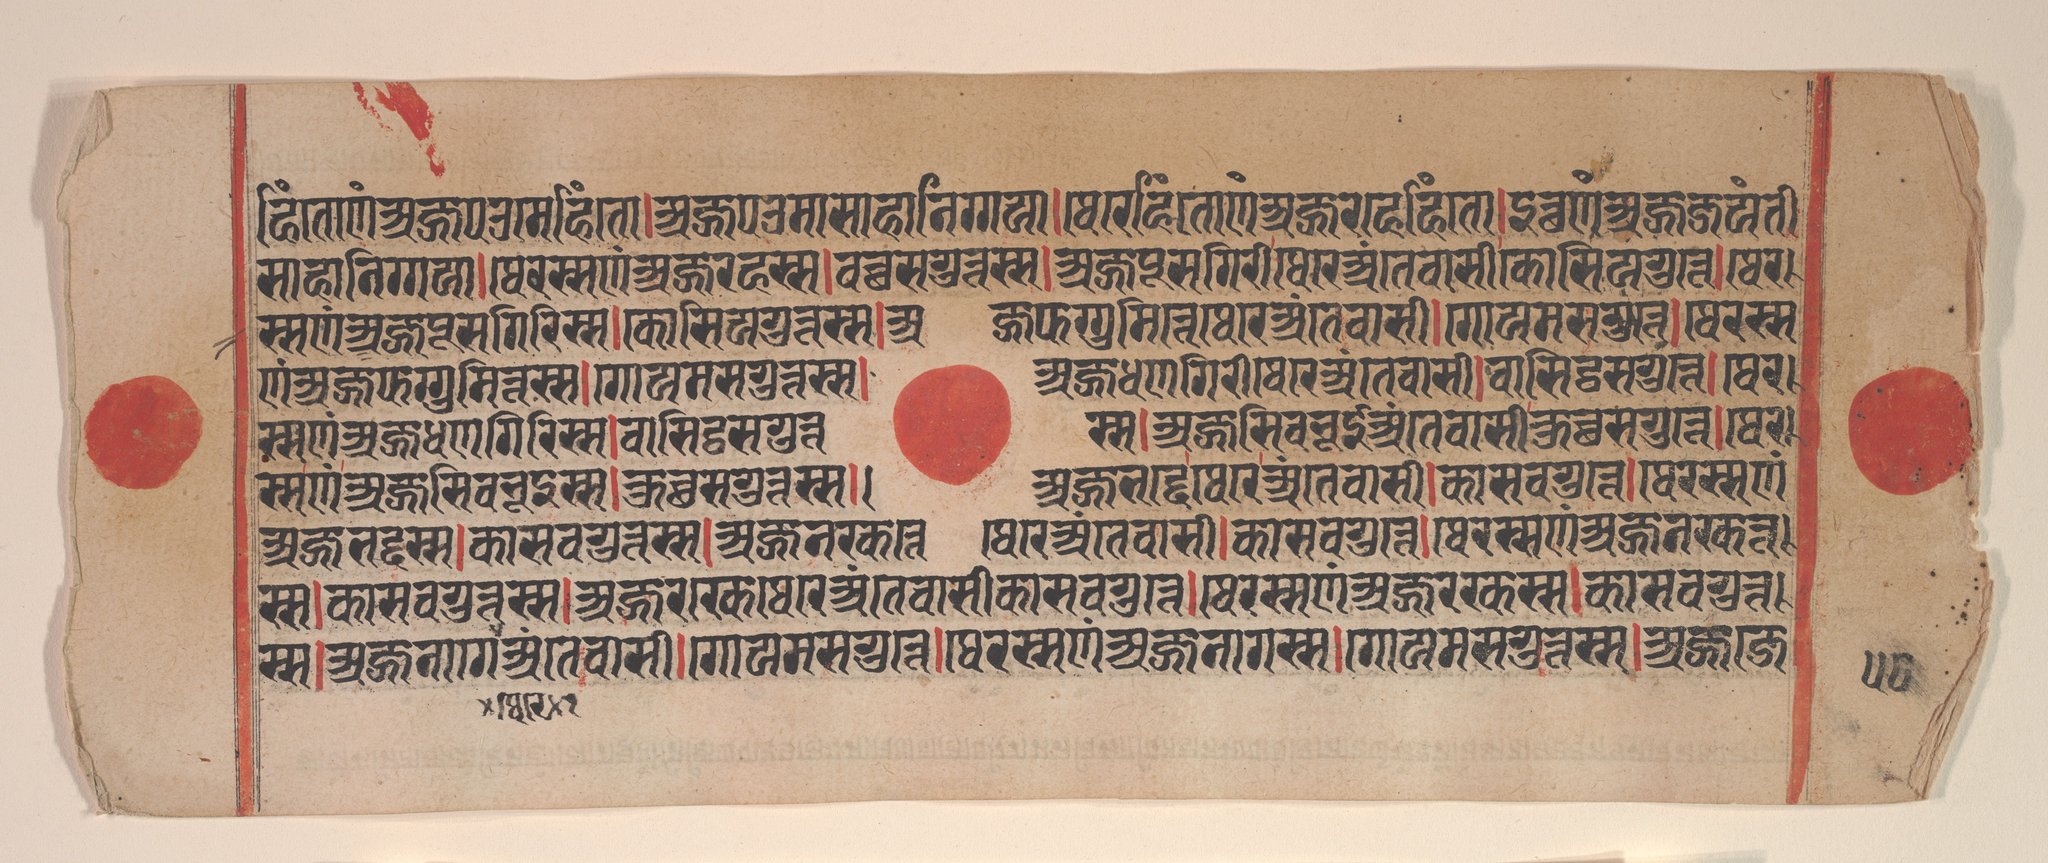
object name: folio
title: Leaf from a Kalpa Sutra (Jain Book of Rituals)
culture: indian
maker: bhadrabahu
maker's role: artist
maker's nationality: indian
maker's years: 356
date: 1401-1500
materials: gold, ink, paper, watercolor